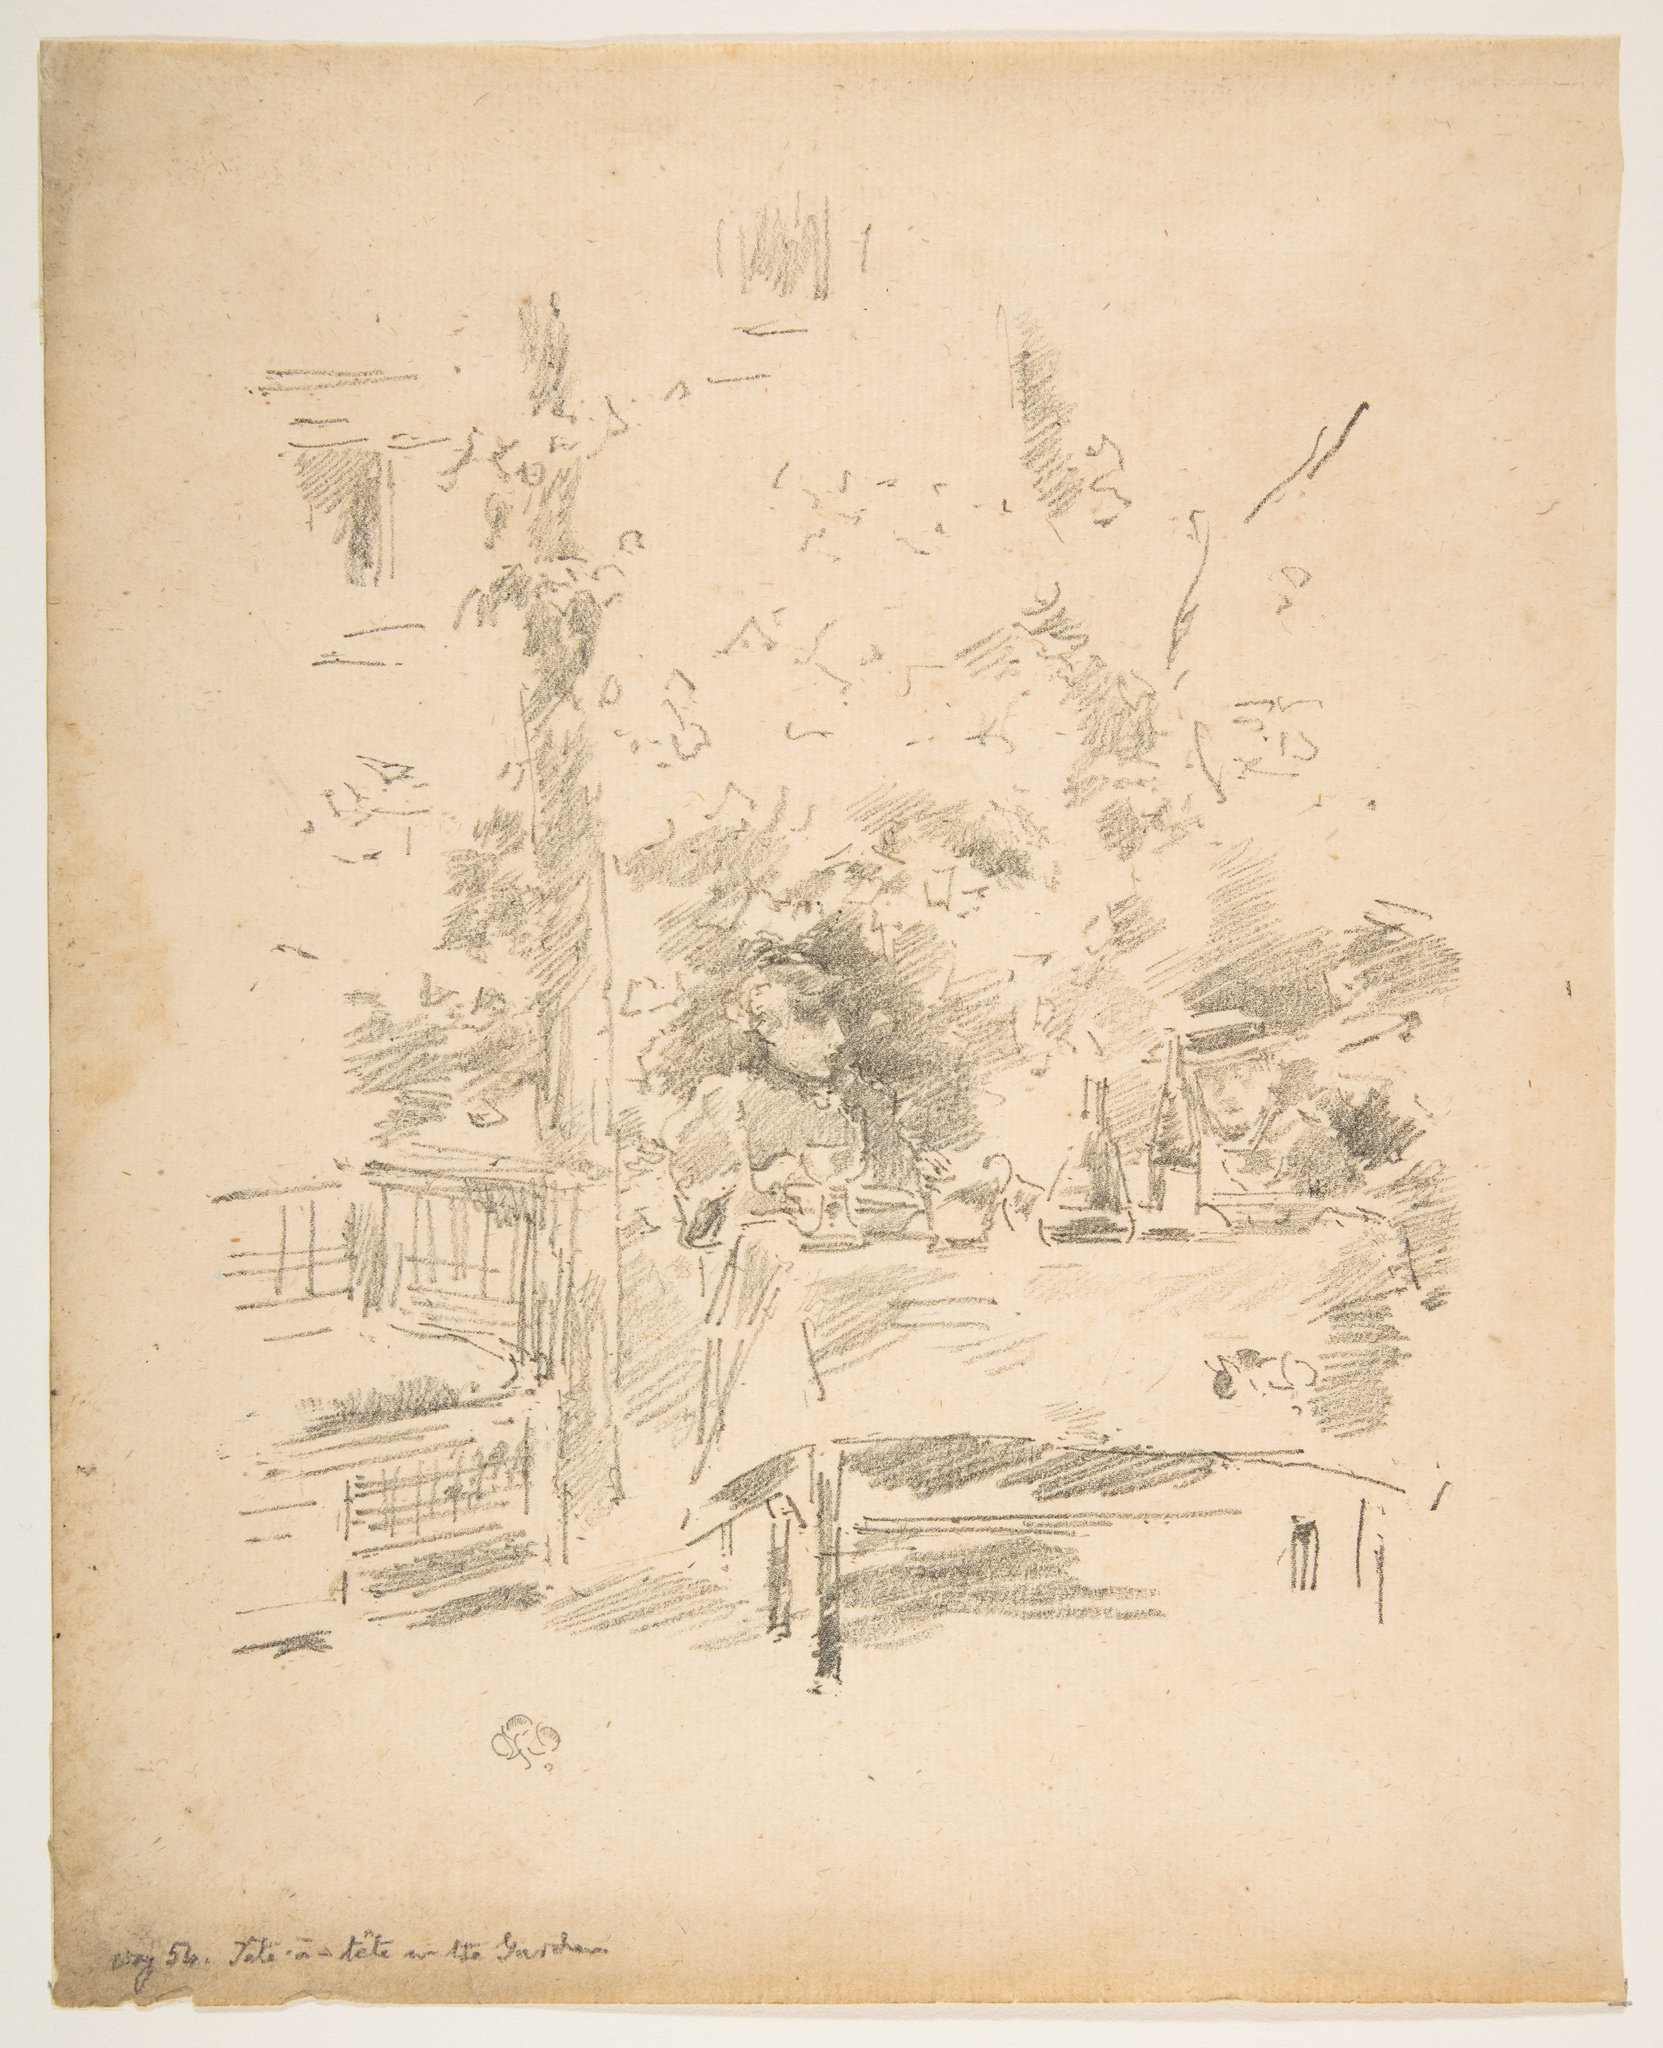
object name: print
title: Tête-à-tête in the Garden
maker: james mcneill whistler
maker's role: artist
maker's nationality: american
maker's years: 1834-1903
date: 1894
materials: ink, paper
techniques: printing, lithography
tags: human figures,gardens,tables